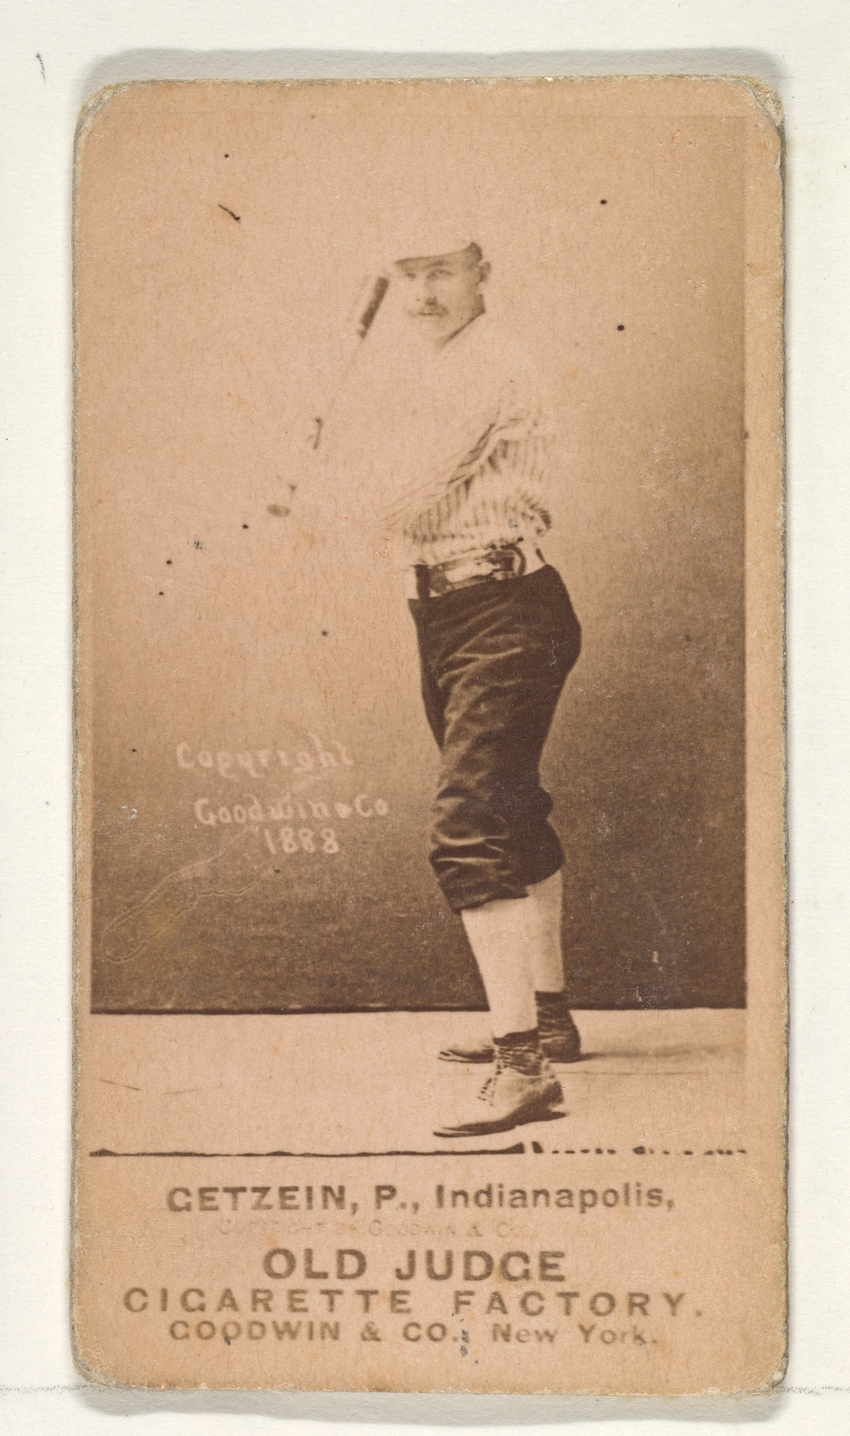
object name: baseball card, photograph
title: Getzein, Pitcher, Indianapolis, from the Old Judge series (N172) for Old Judge Cigarettes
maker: goodwin & company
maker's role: publisher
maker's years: 1850-1950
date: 1888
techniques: albumen silver print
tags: men,portraits,baseball,athletes